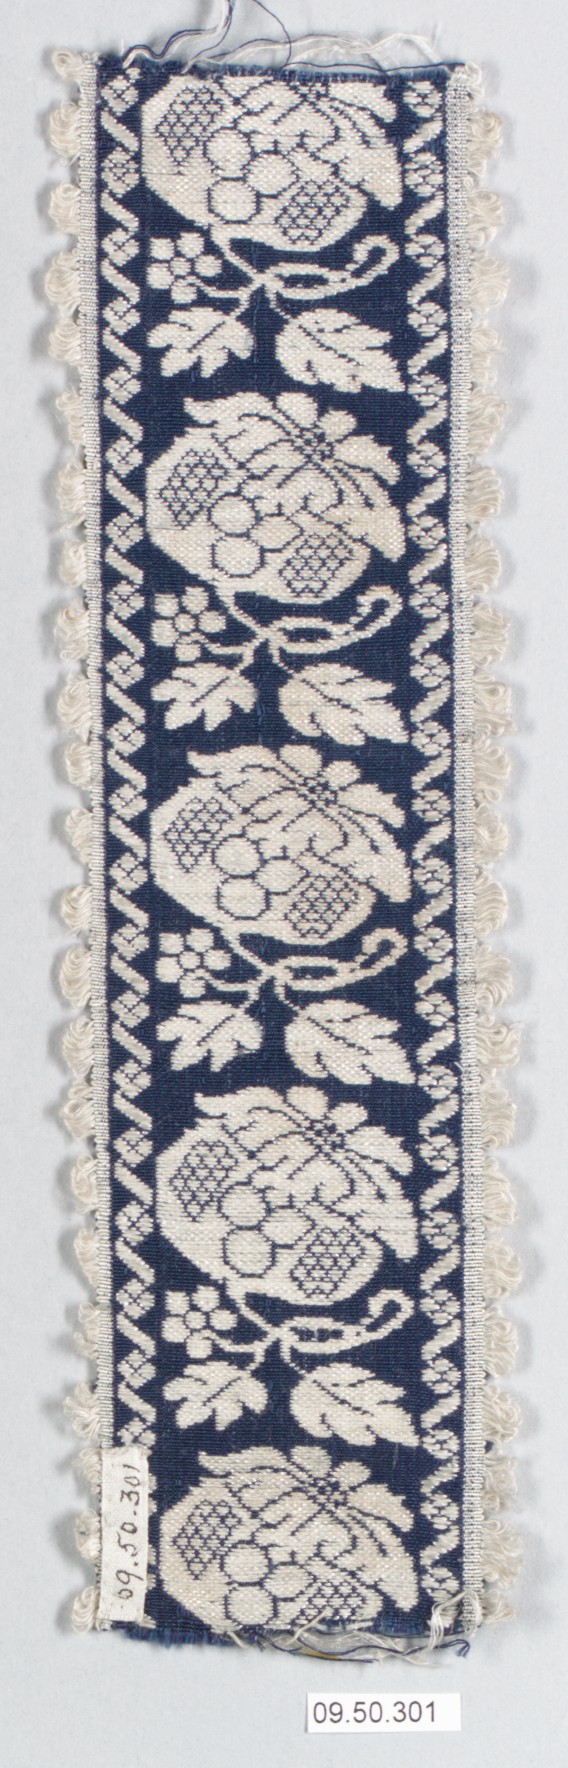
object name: galloon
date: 1701-1800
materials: cotton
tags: flowers,leaves